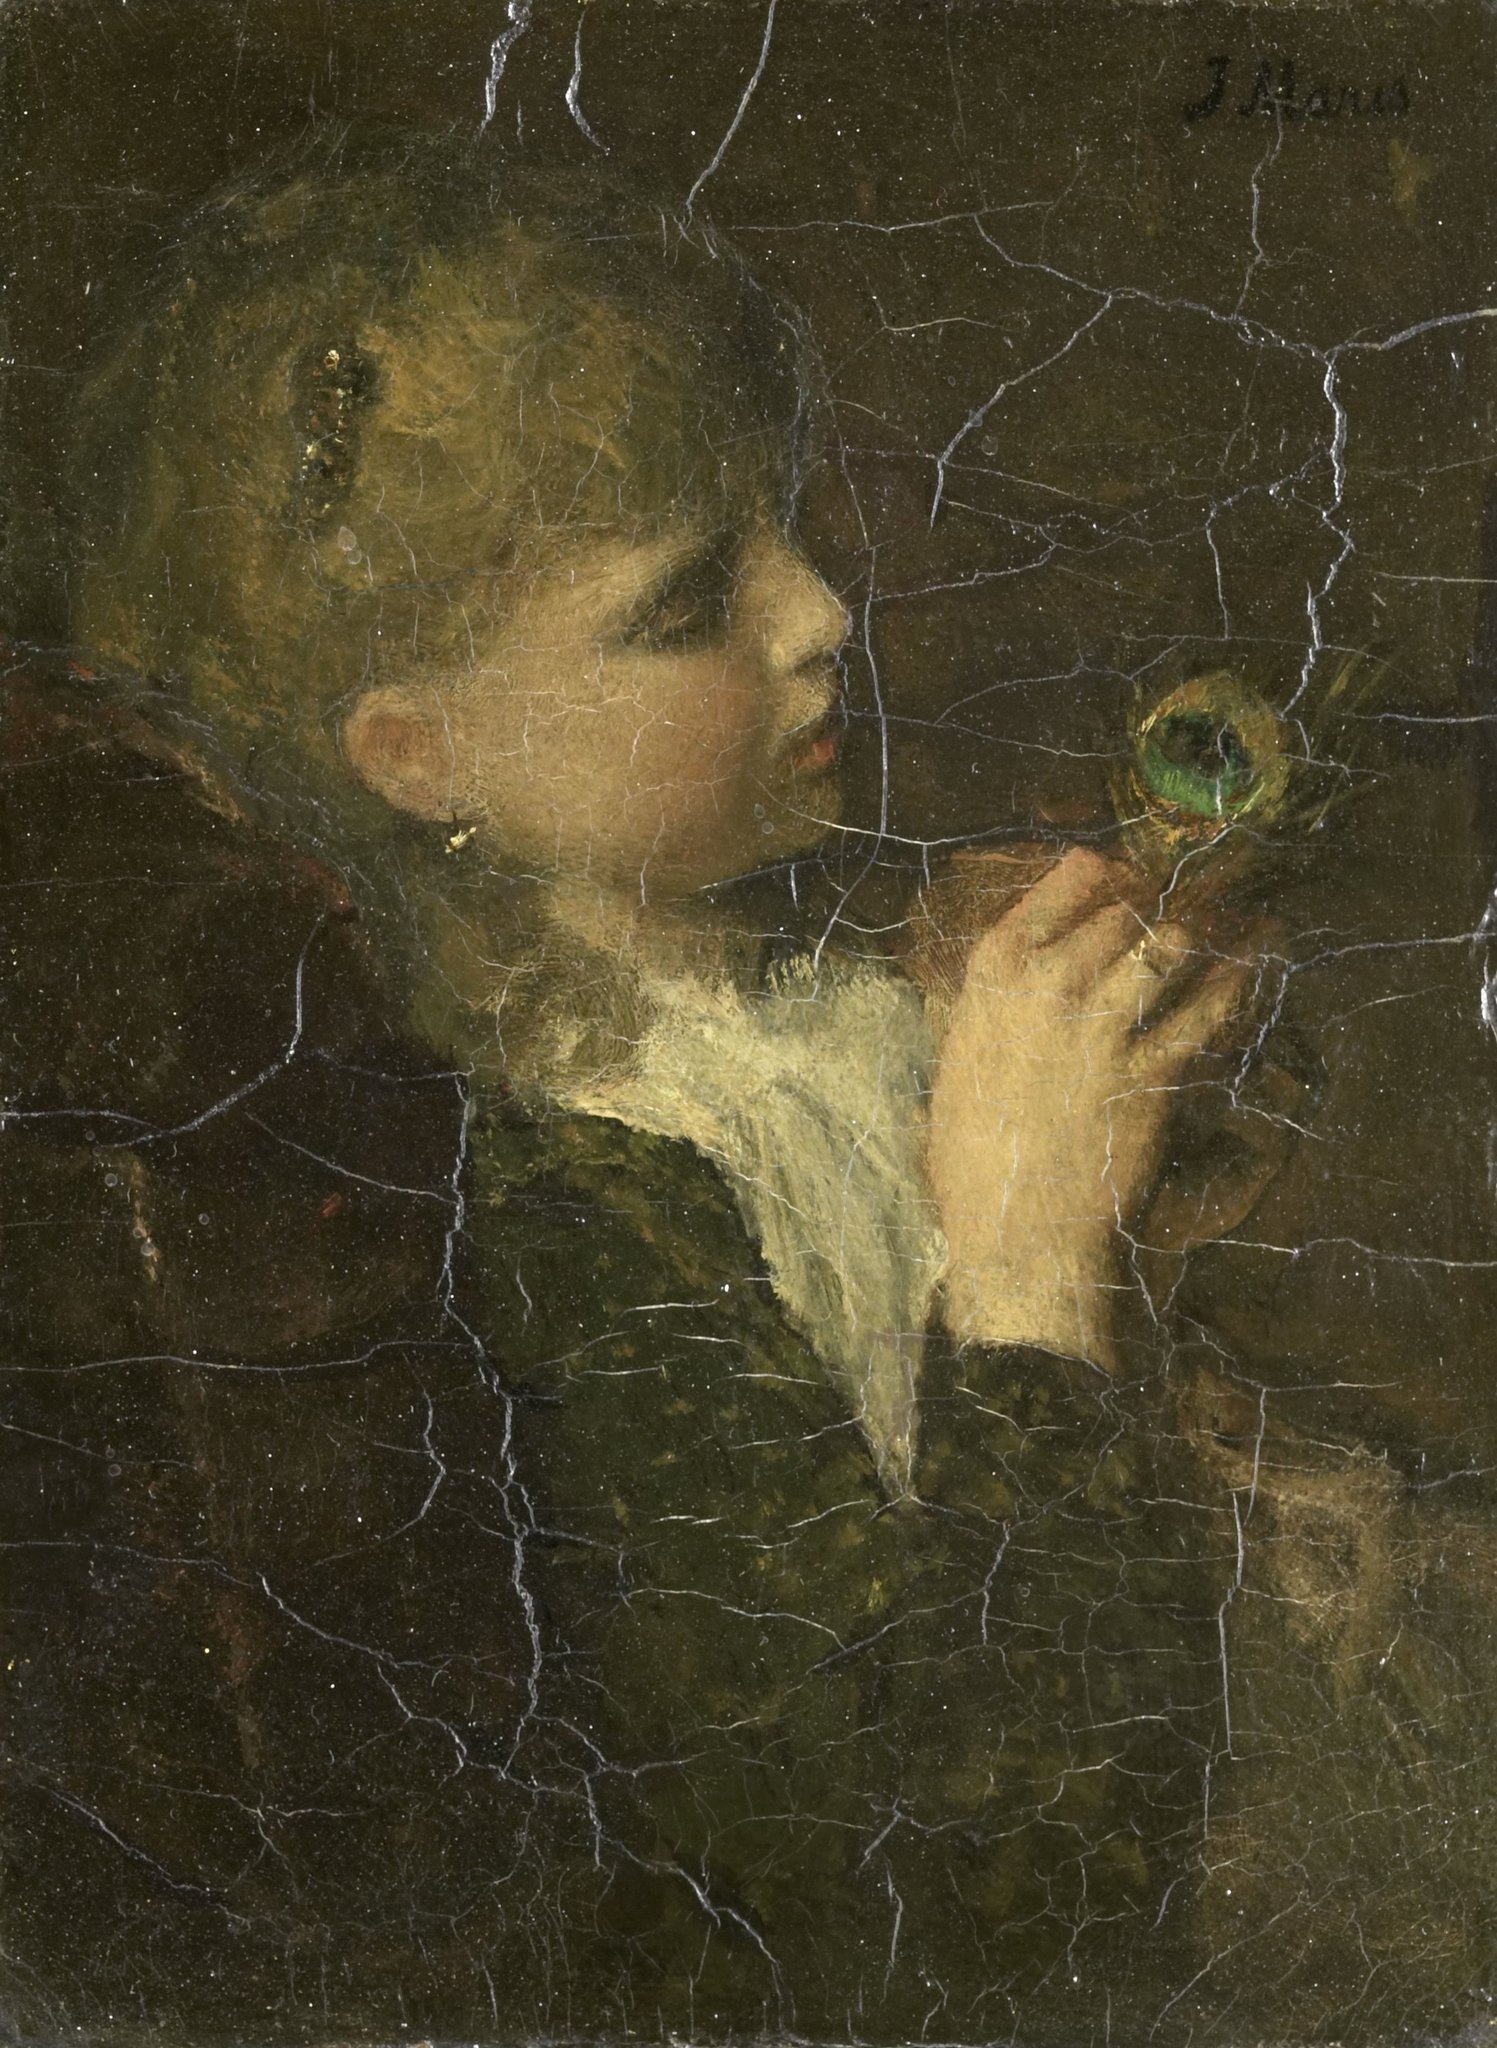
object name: painting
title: Girl with a Peacock Feather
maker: jacob maris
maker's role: draughtsman, painter, print maker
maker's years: 1837-1899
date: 1877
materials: canvas, oil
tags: adolescent, young woman, maiden, historical persons not known by name - bb - woman, ornamental birds: peacock (+ feathers)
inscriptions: signature: ‘J Maris’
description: Portret van een meisje zittend in een stoel met een pauwenveer in de handen.